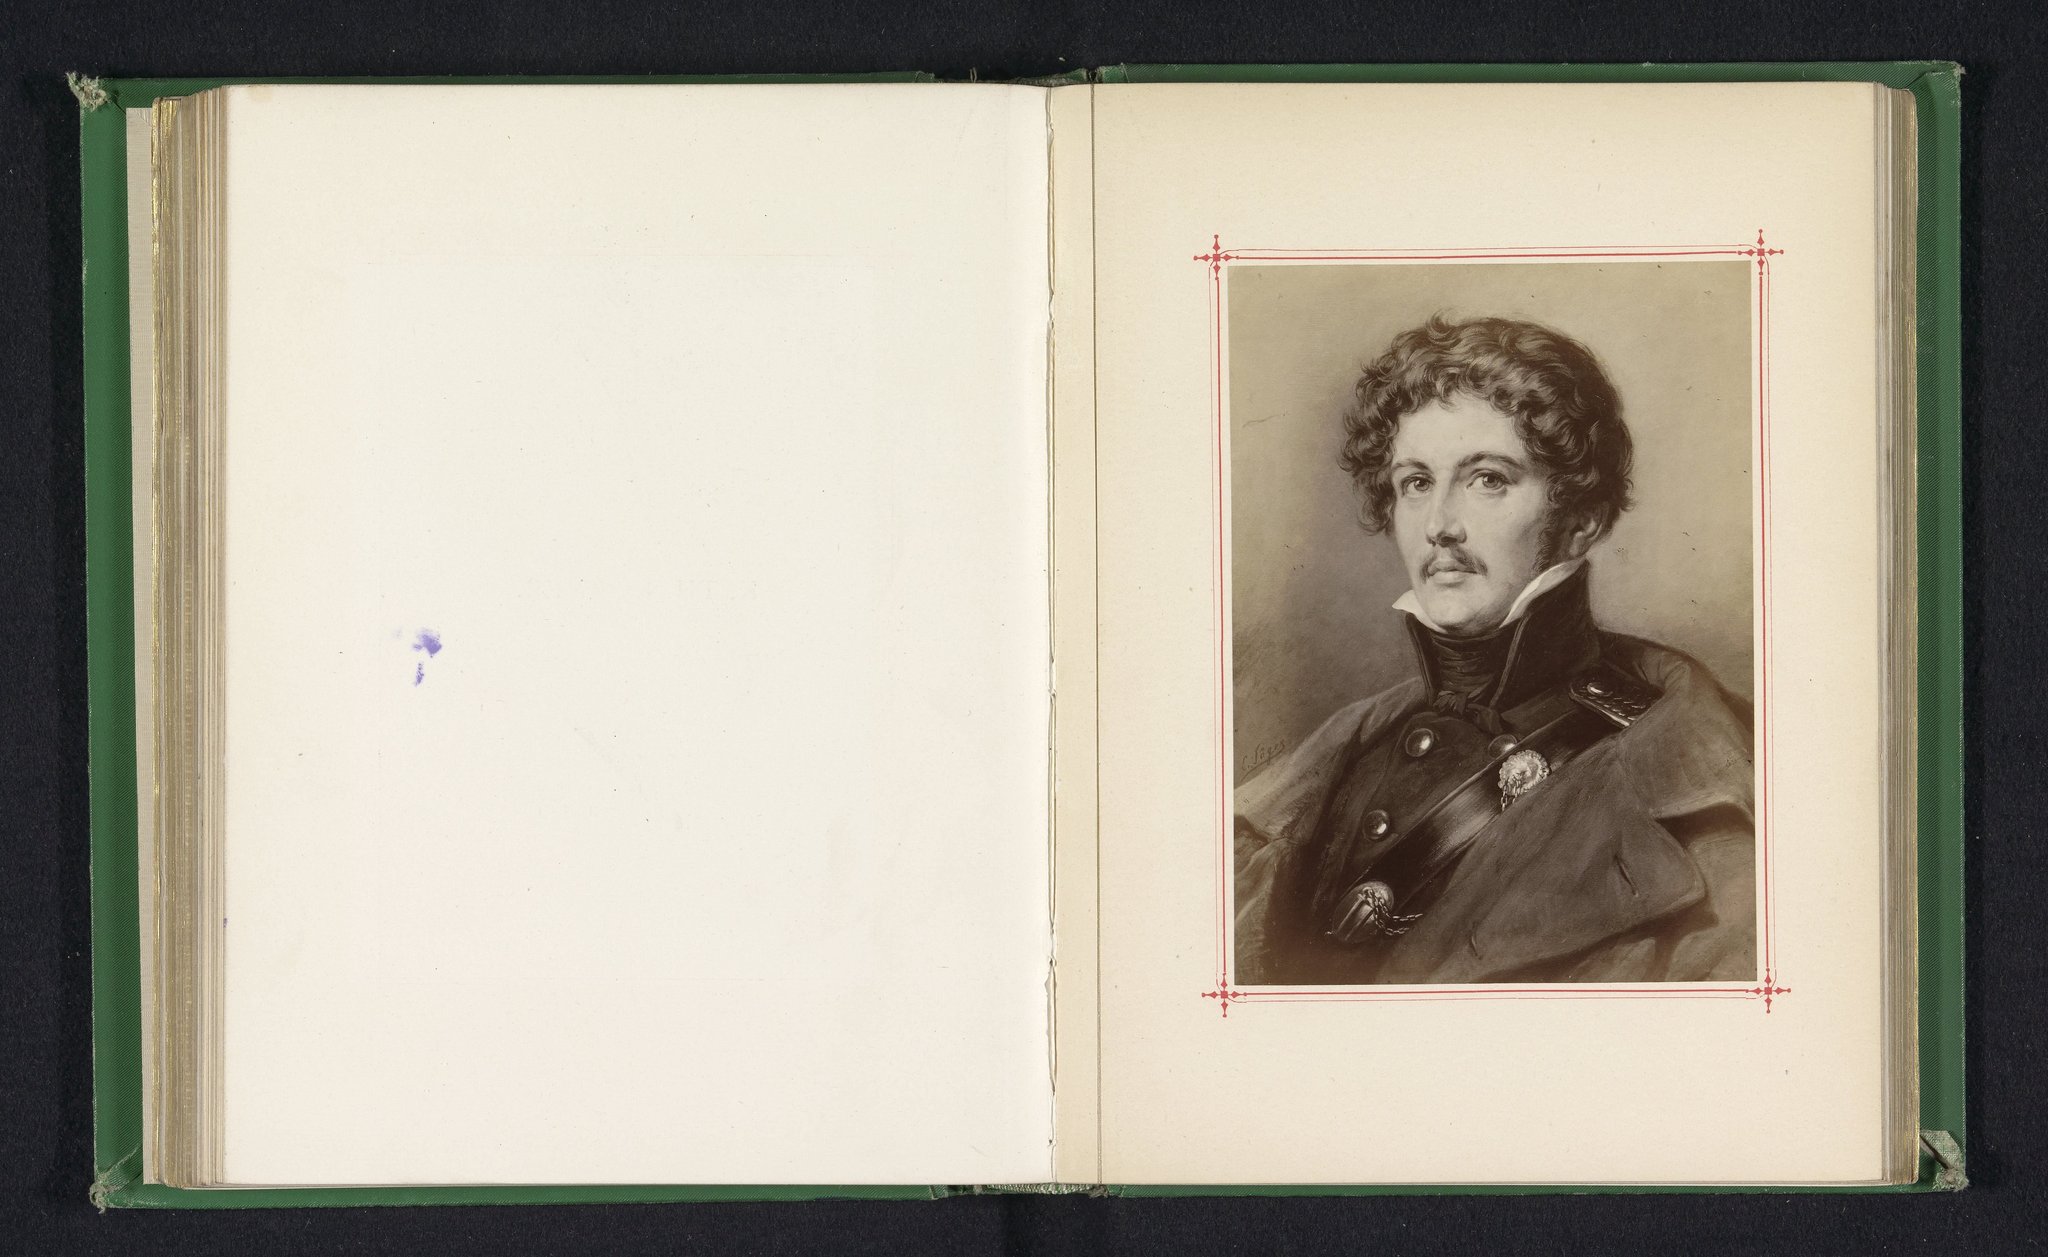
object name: page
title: Fotoreproductie van een portret van Theodor Körner door Carl Jäger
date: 1868-1878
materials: photographic support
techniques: albumen print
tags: writer, poet, author